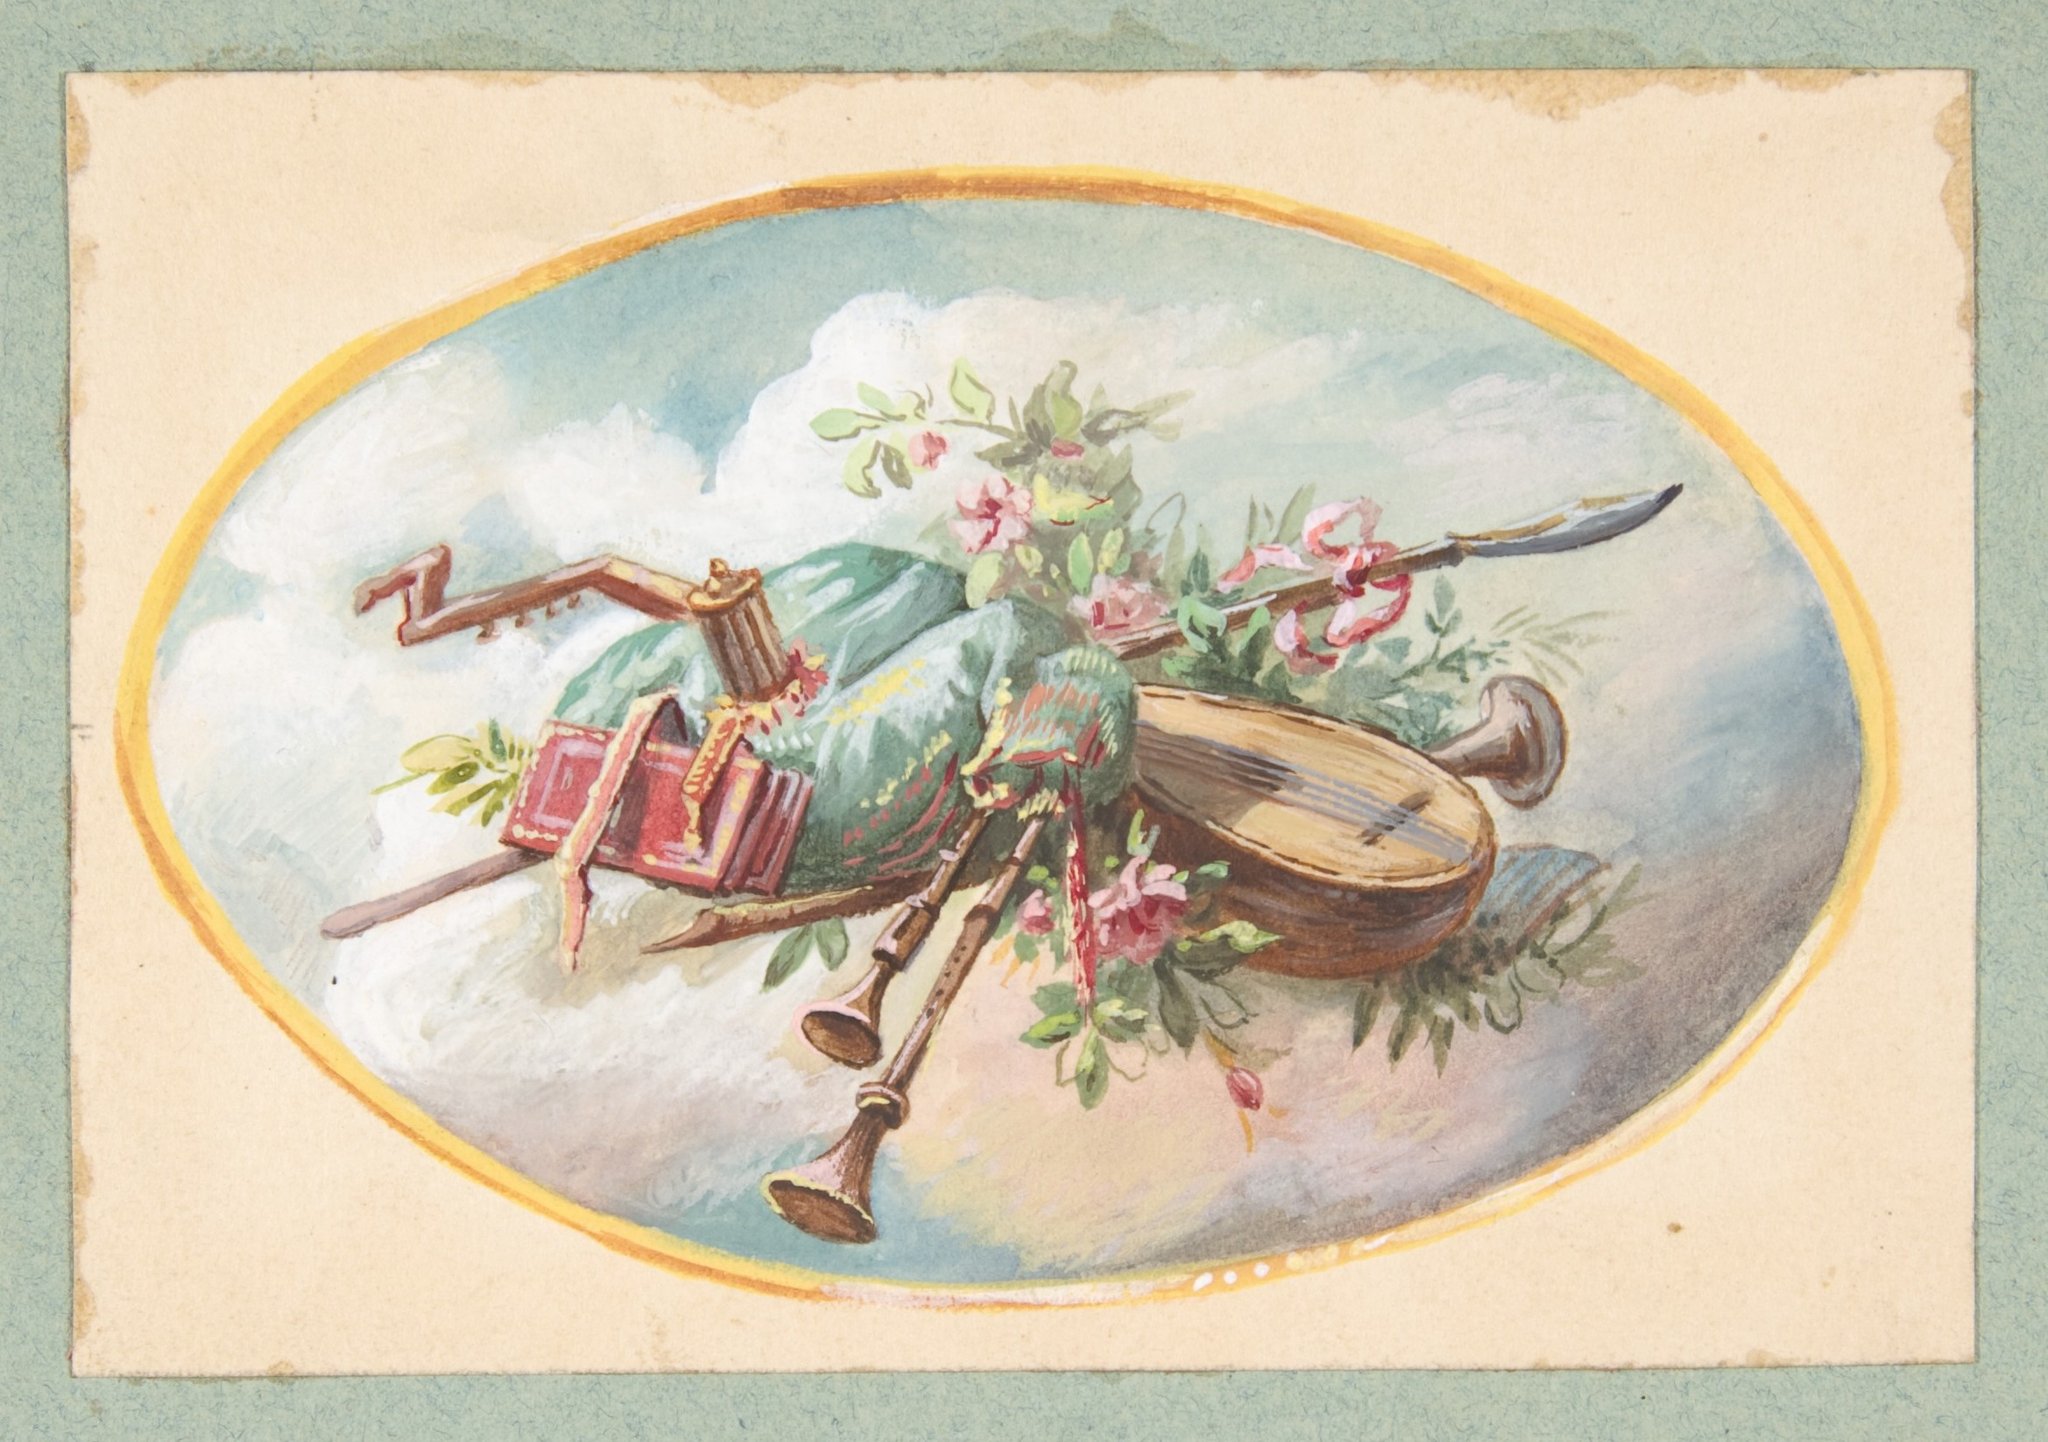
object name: drawing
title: Allegory of the Arts (Music?)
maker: jules-edmond-charles lachaise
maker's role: artist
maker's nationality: french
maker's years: 1897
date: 1851-1900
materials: gouache, graphite, watercolor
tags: bagpipes,horns,lutes